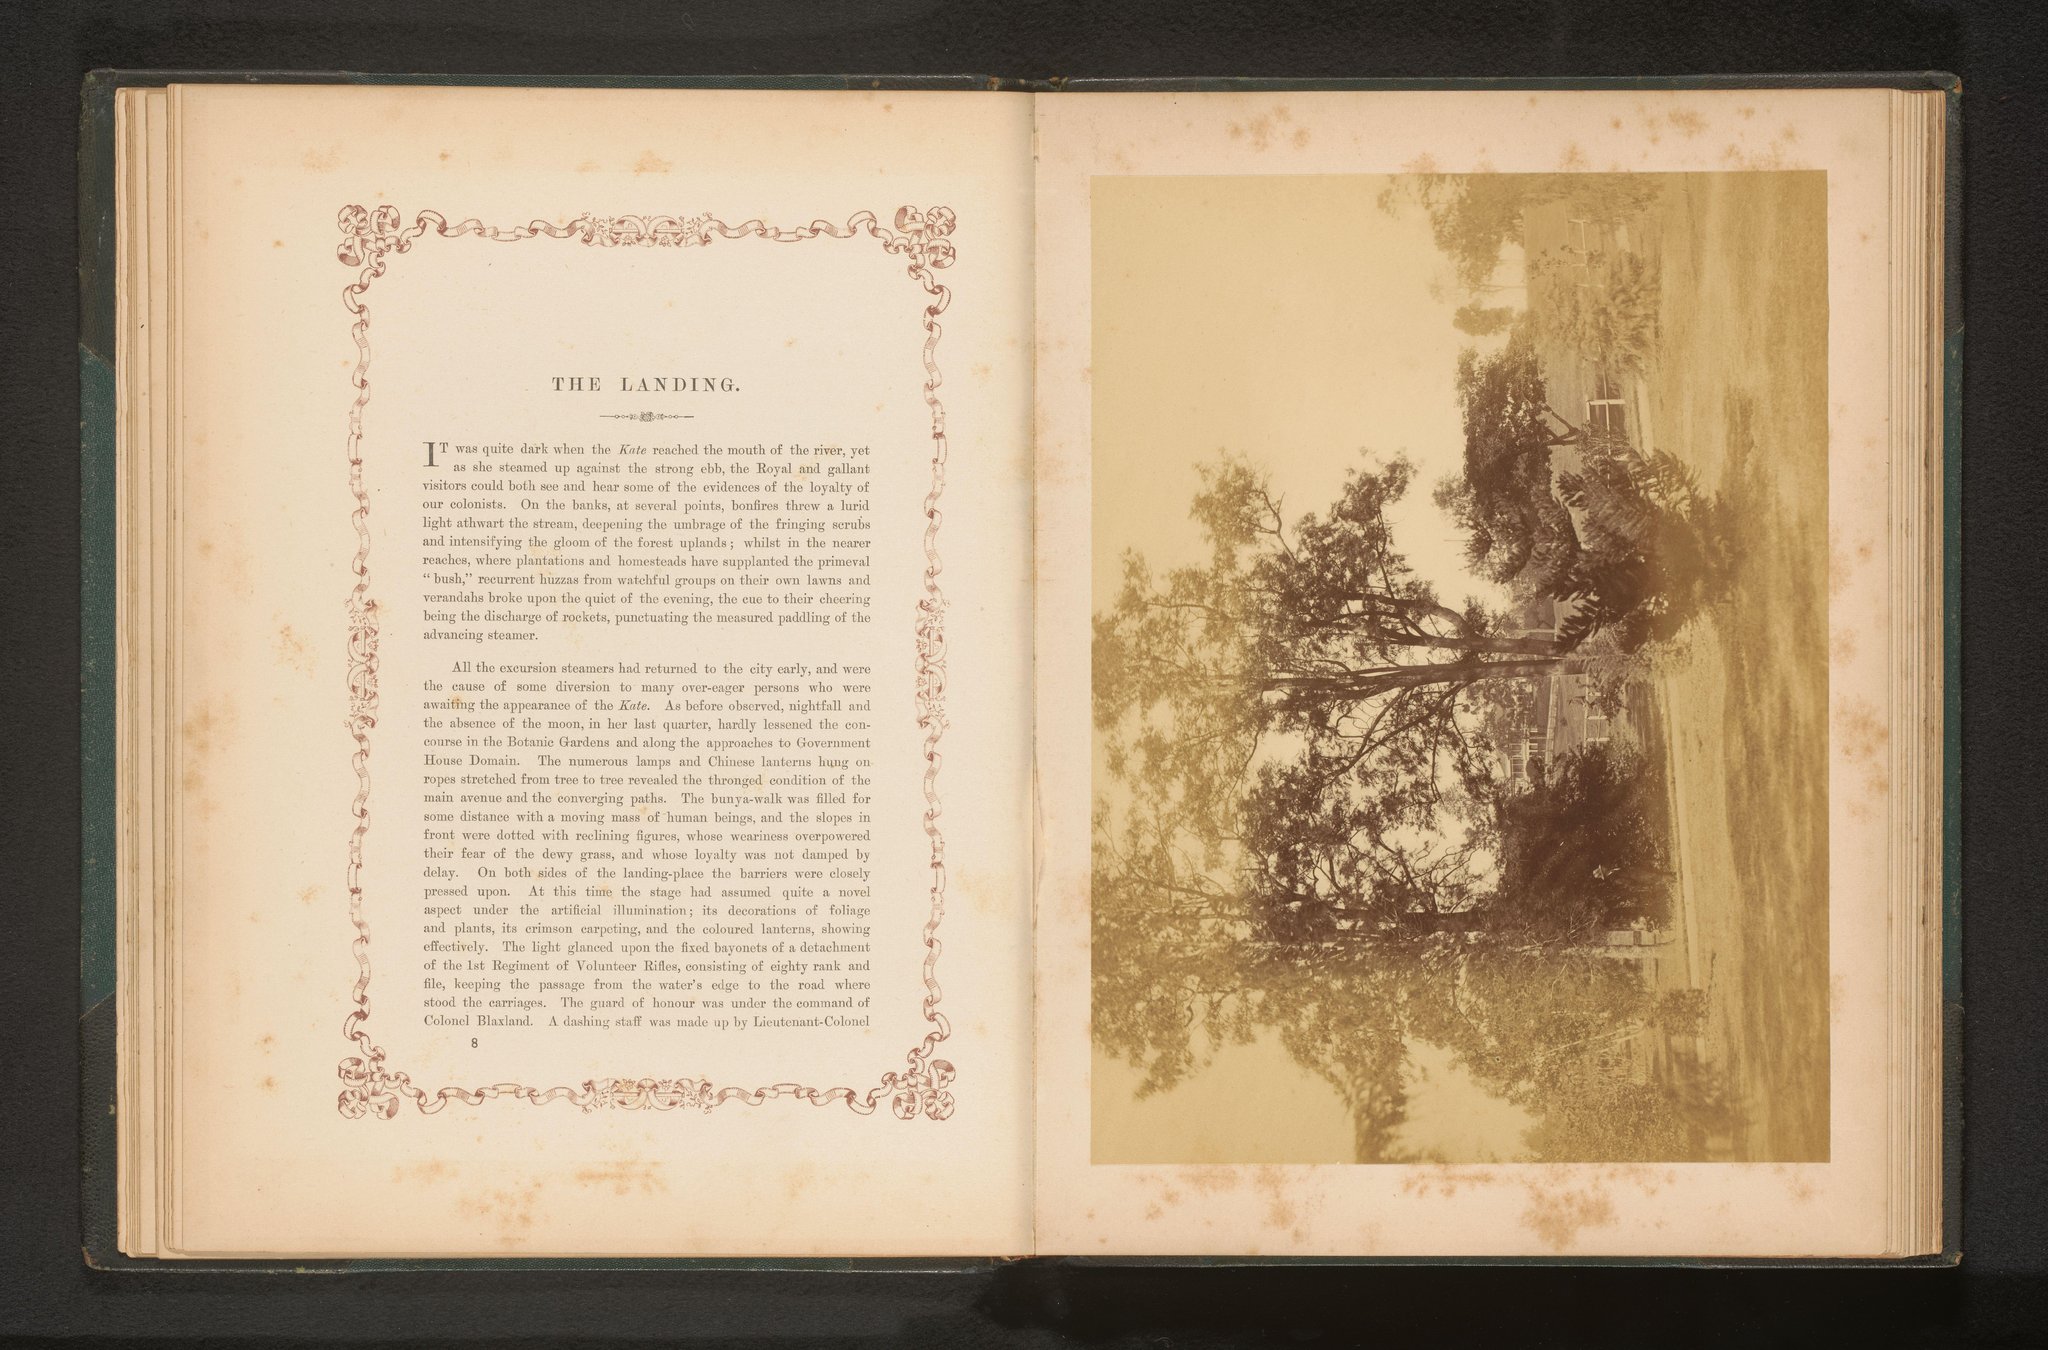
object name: page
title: Gezicht op het Government House te Brisbane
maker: Anonymous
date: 1880-1881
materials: photographic support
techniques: albumen print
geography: brisbane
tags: façade (of house or building), colonial government